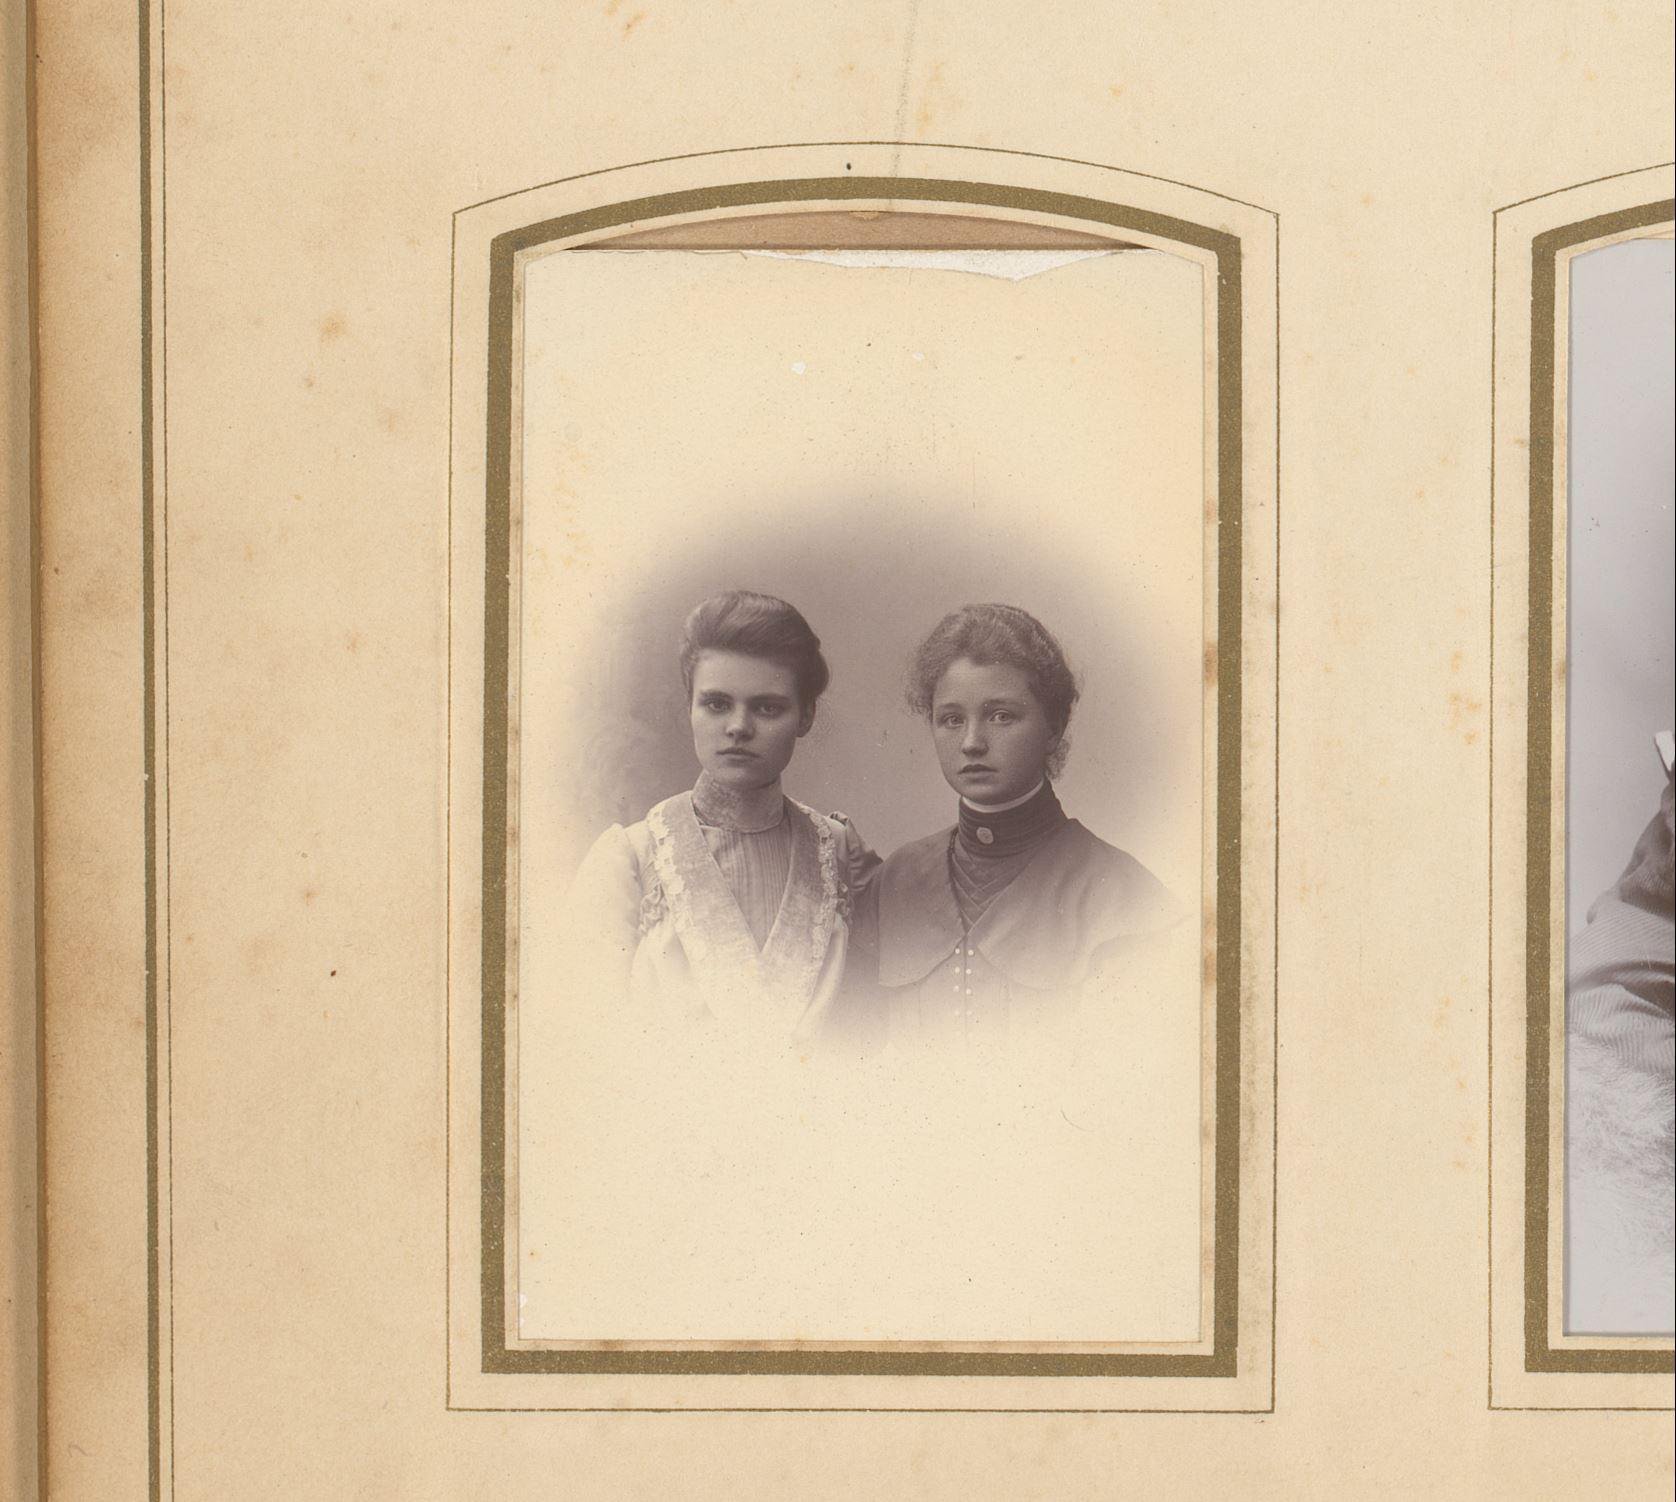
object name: carte de visite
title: Portret van twee jonge vrouwen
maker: Anonymous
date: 1880-1920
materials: cardboard, photographic support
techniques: collodion silver print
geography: netherlands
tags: historical persons - bb - woman, adolescent, young woman, maiden (+ two persons)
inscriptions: number: ‘225/ 350’